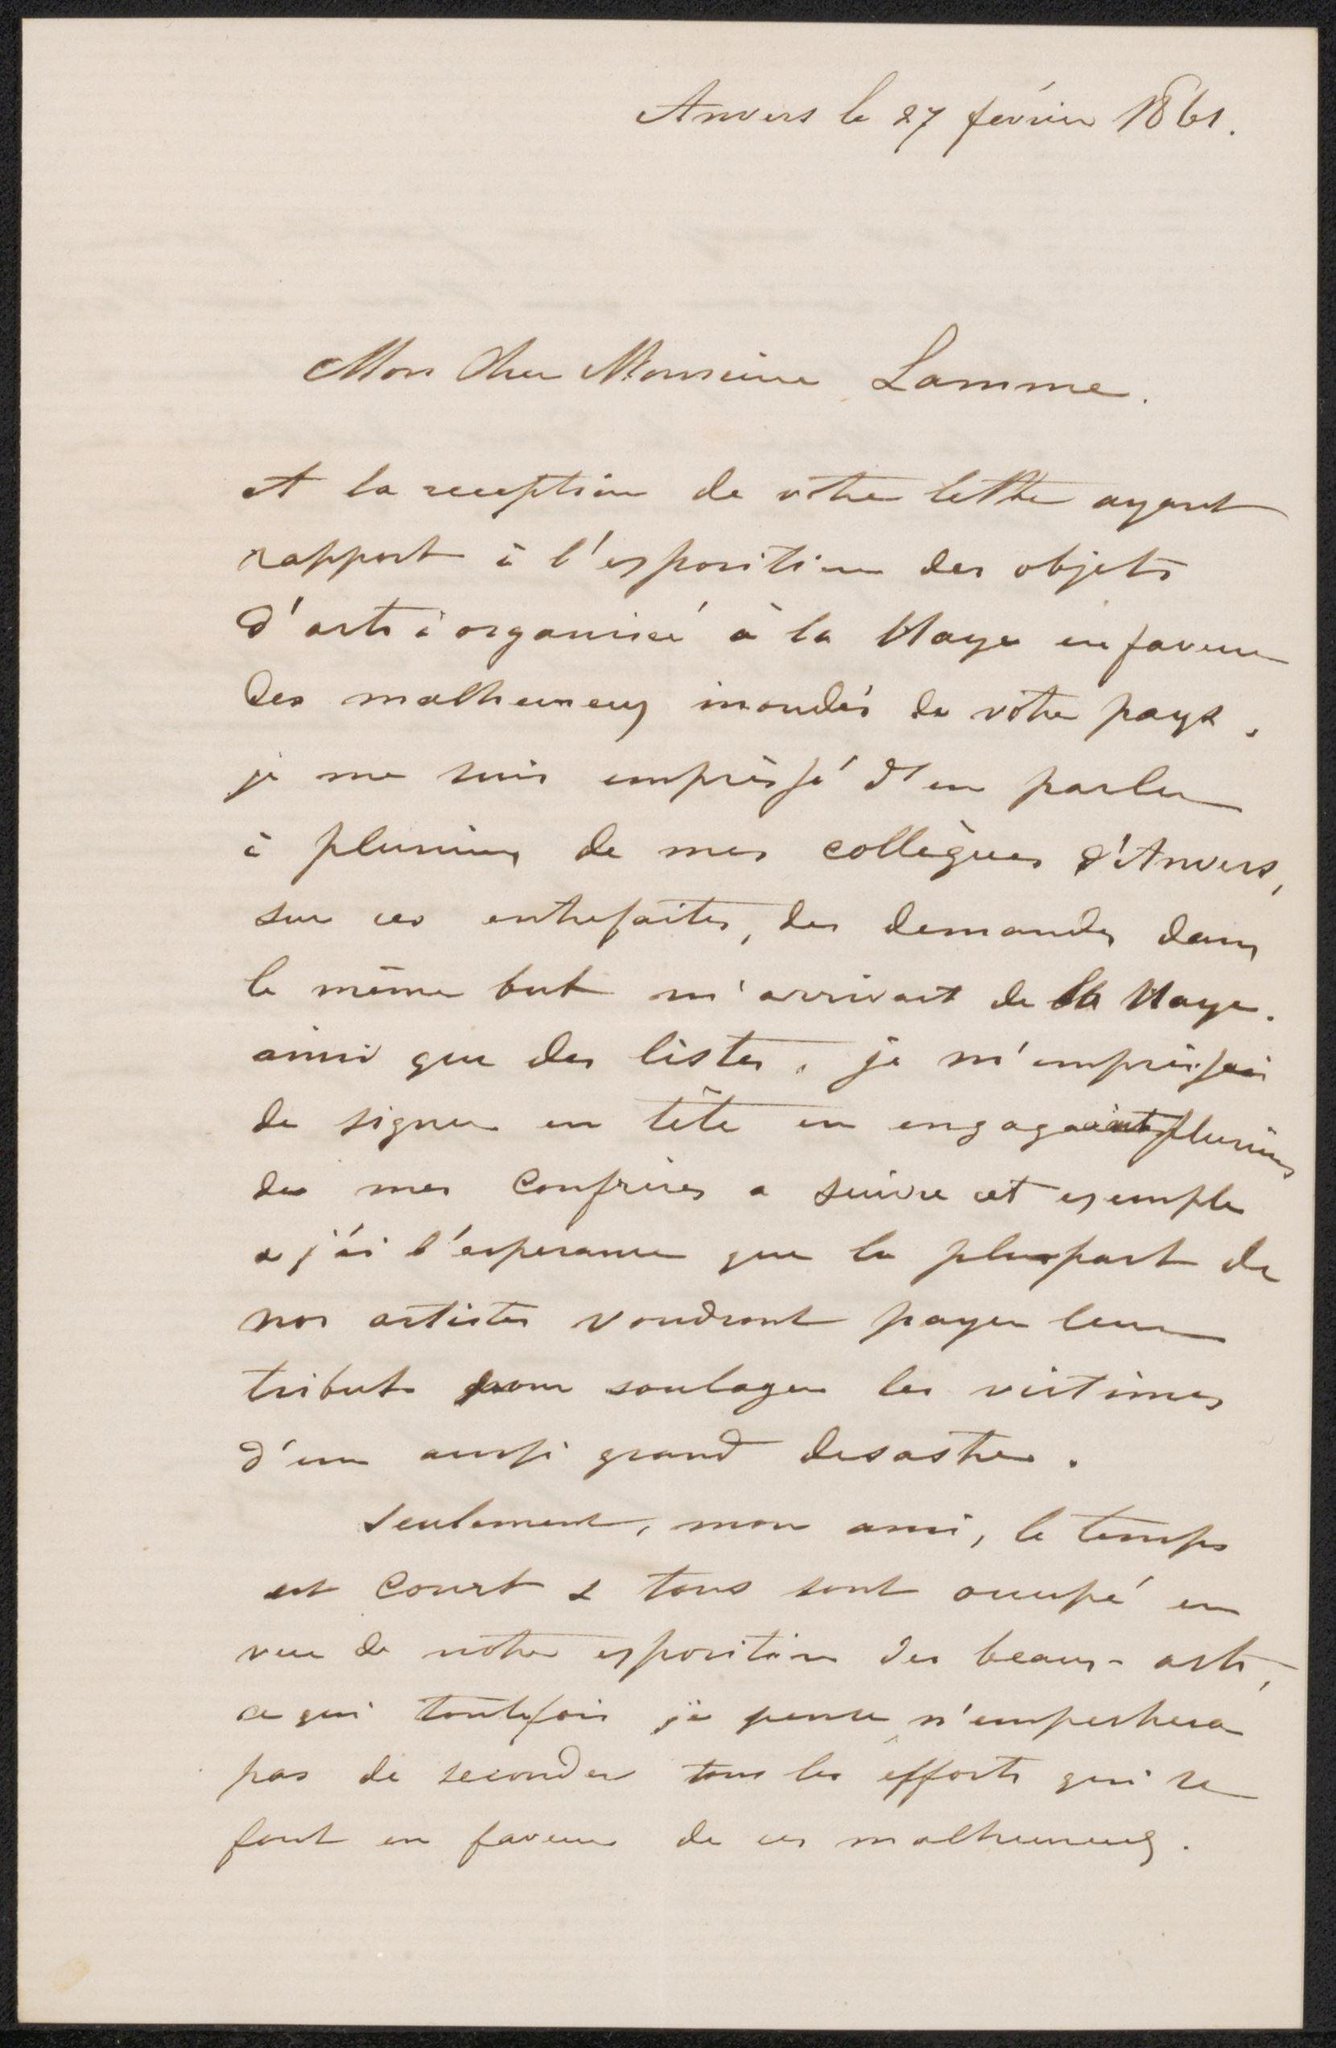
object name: letter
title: Brief aan Ary Johannes Lamme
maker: nicaise de keyser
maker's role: draughtsman, painter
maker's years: 1813-1887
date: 1861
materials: ink, paper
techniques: pen, writing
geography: antwerp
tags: dordrecht, print maker, draughtsman, ary johannes lamme, exhibition ~ art, the hague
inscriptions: collector's mark: Lugt 2228